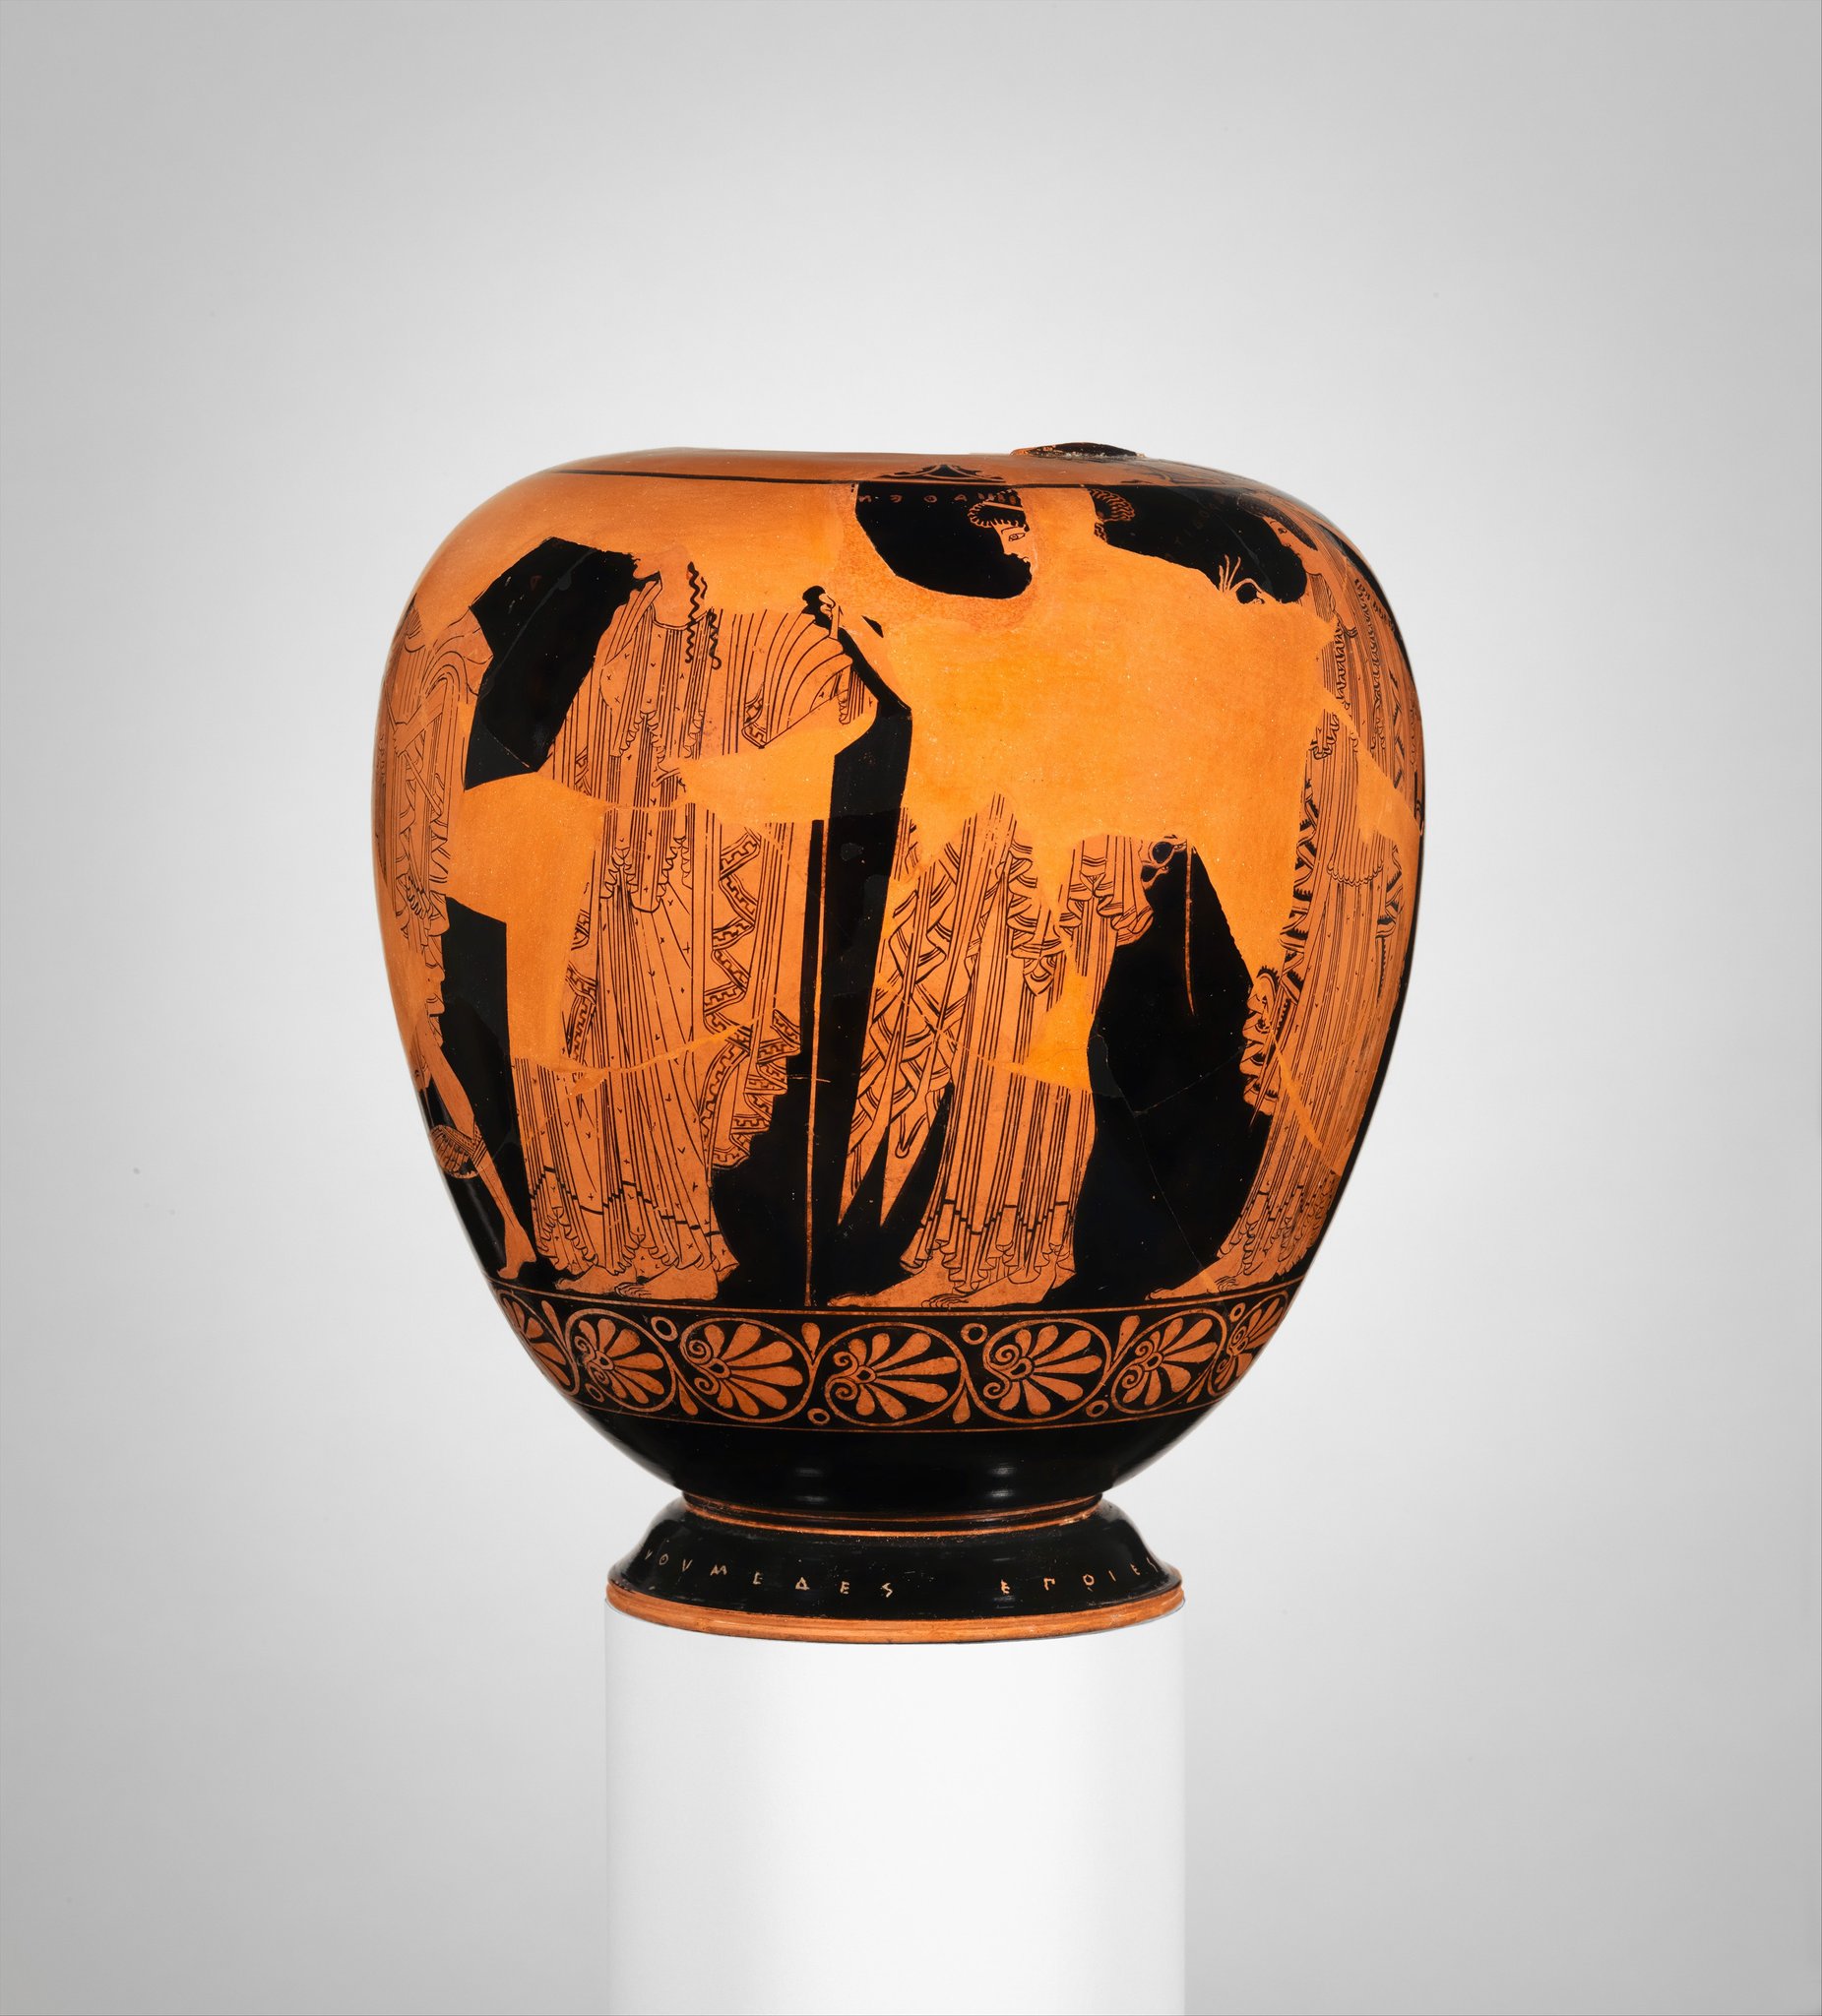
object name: oinochoe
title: Terracotta oinochoe (jug)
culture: greek, attic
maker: euthymides, potter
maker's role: artist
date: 520-510 BCE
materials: terracotta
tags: paris